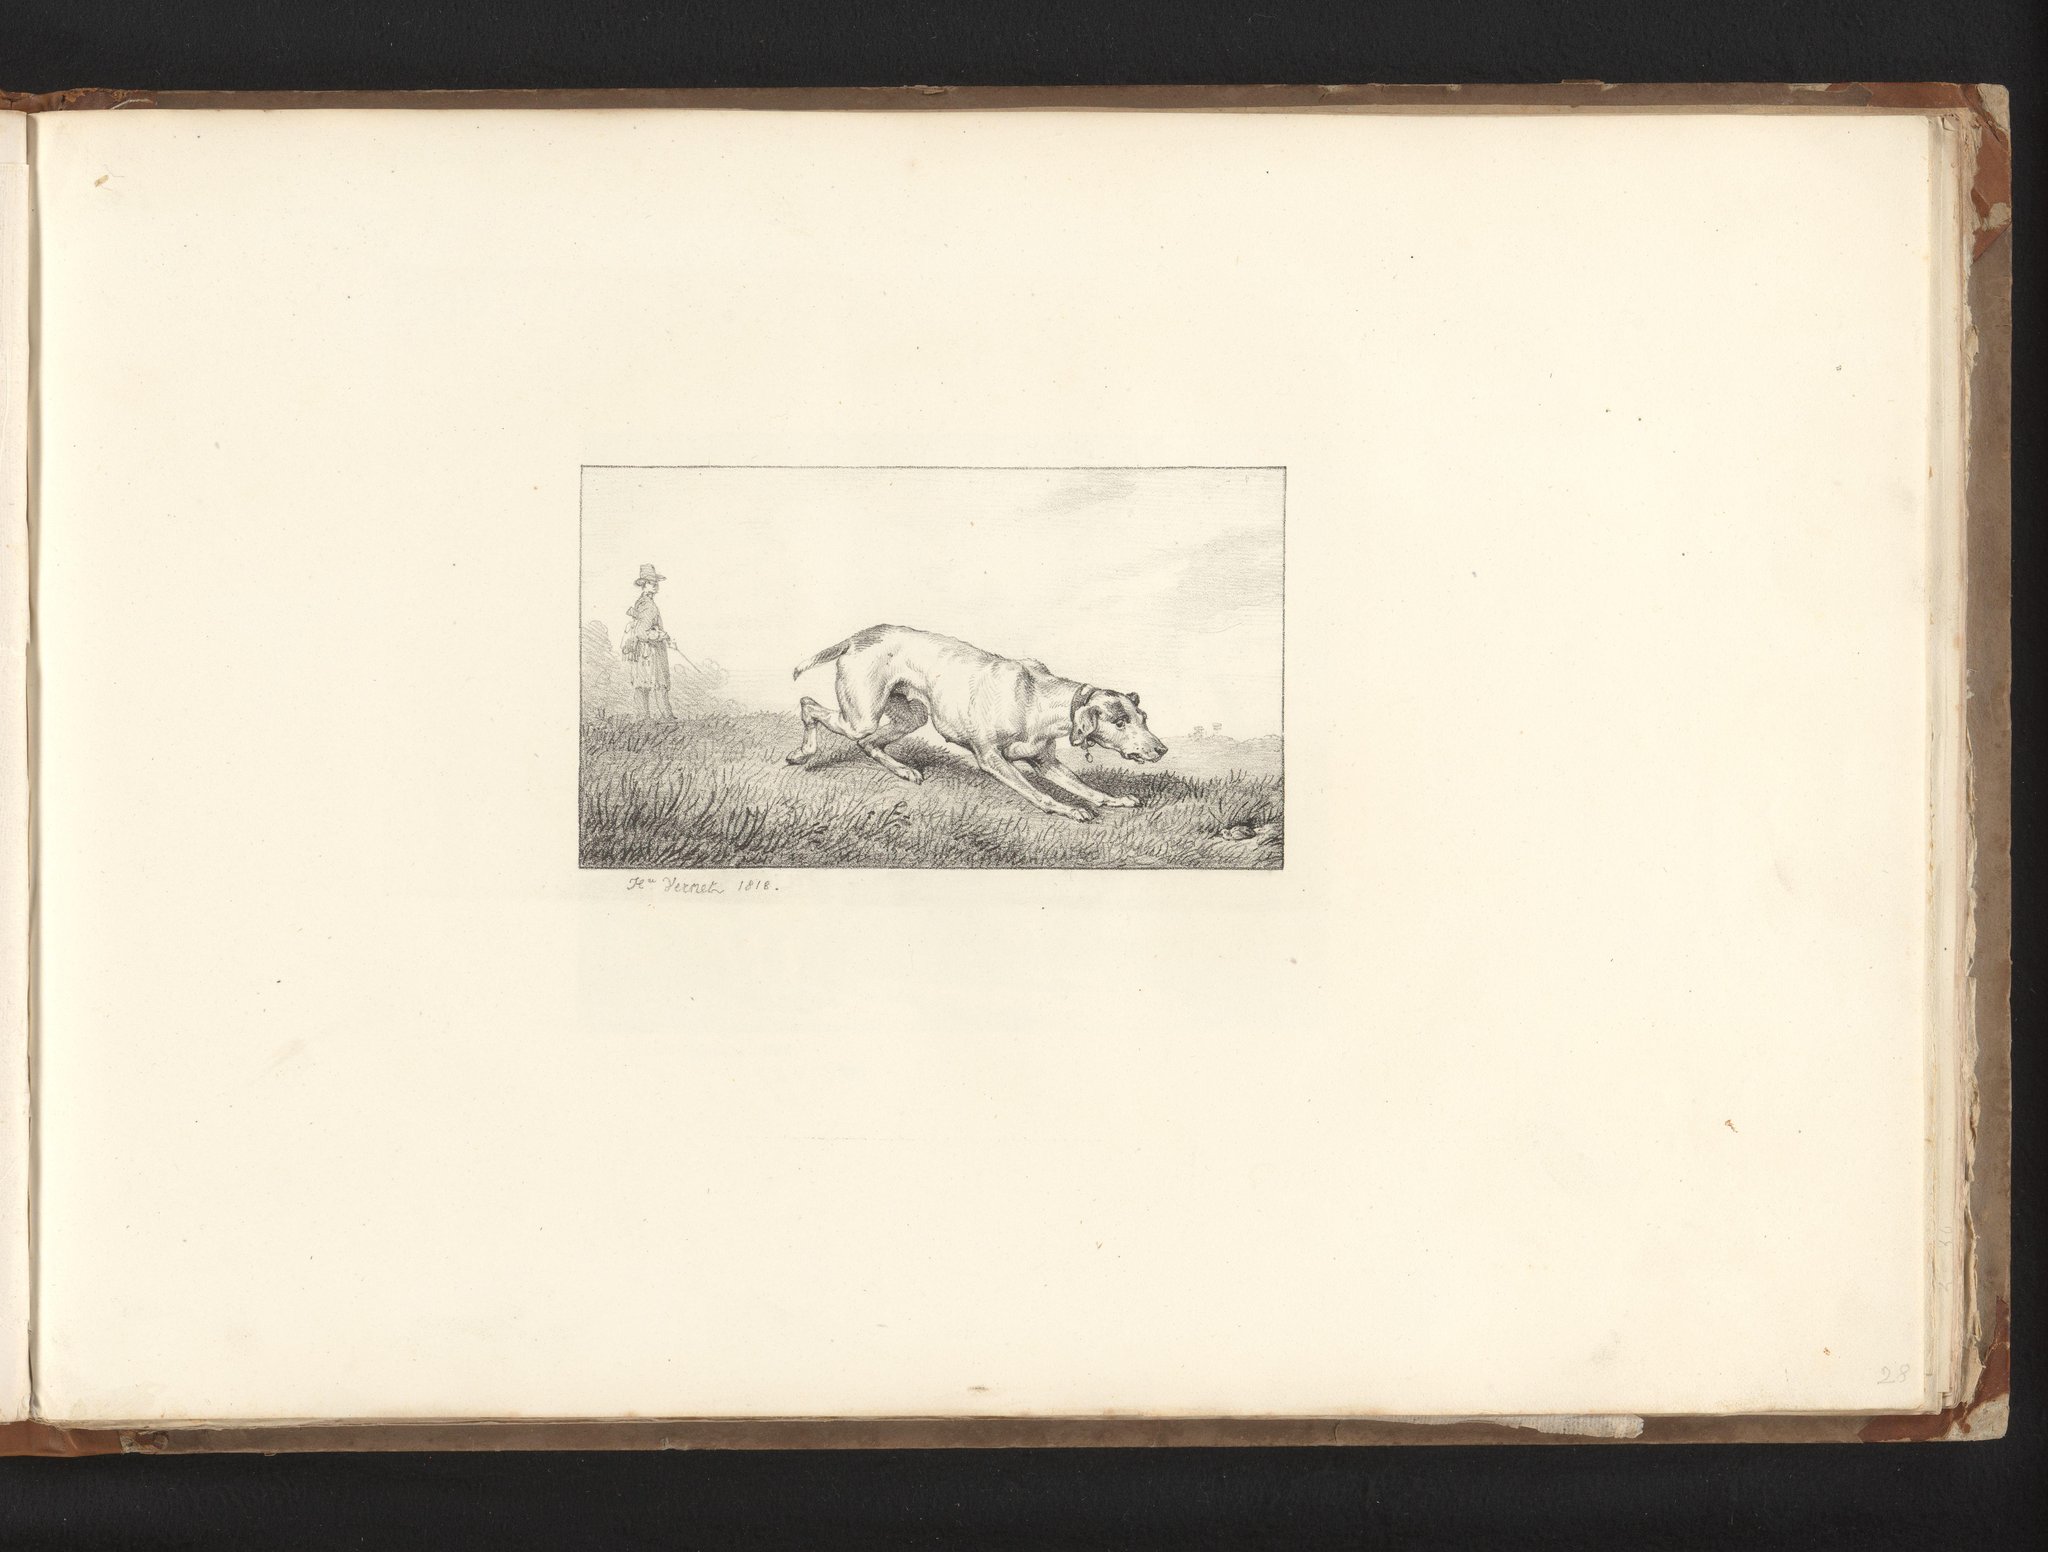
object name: print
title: Jachthond bij een jonge vogel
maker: horace vernet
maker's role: draughtsman, painter, print maker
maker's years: 1789-1863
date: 1818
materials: paper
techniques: lithograph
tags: hunting dogs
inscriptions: date